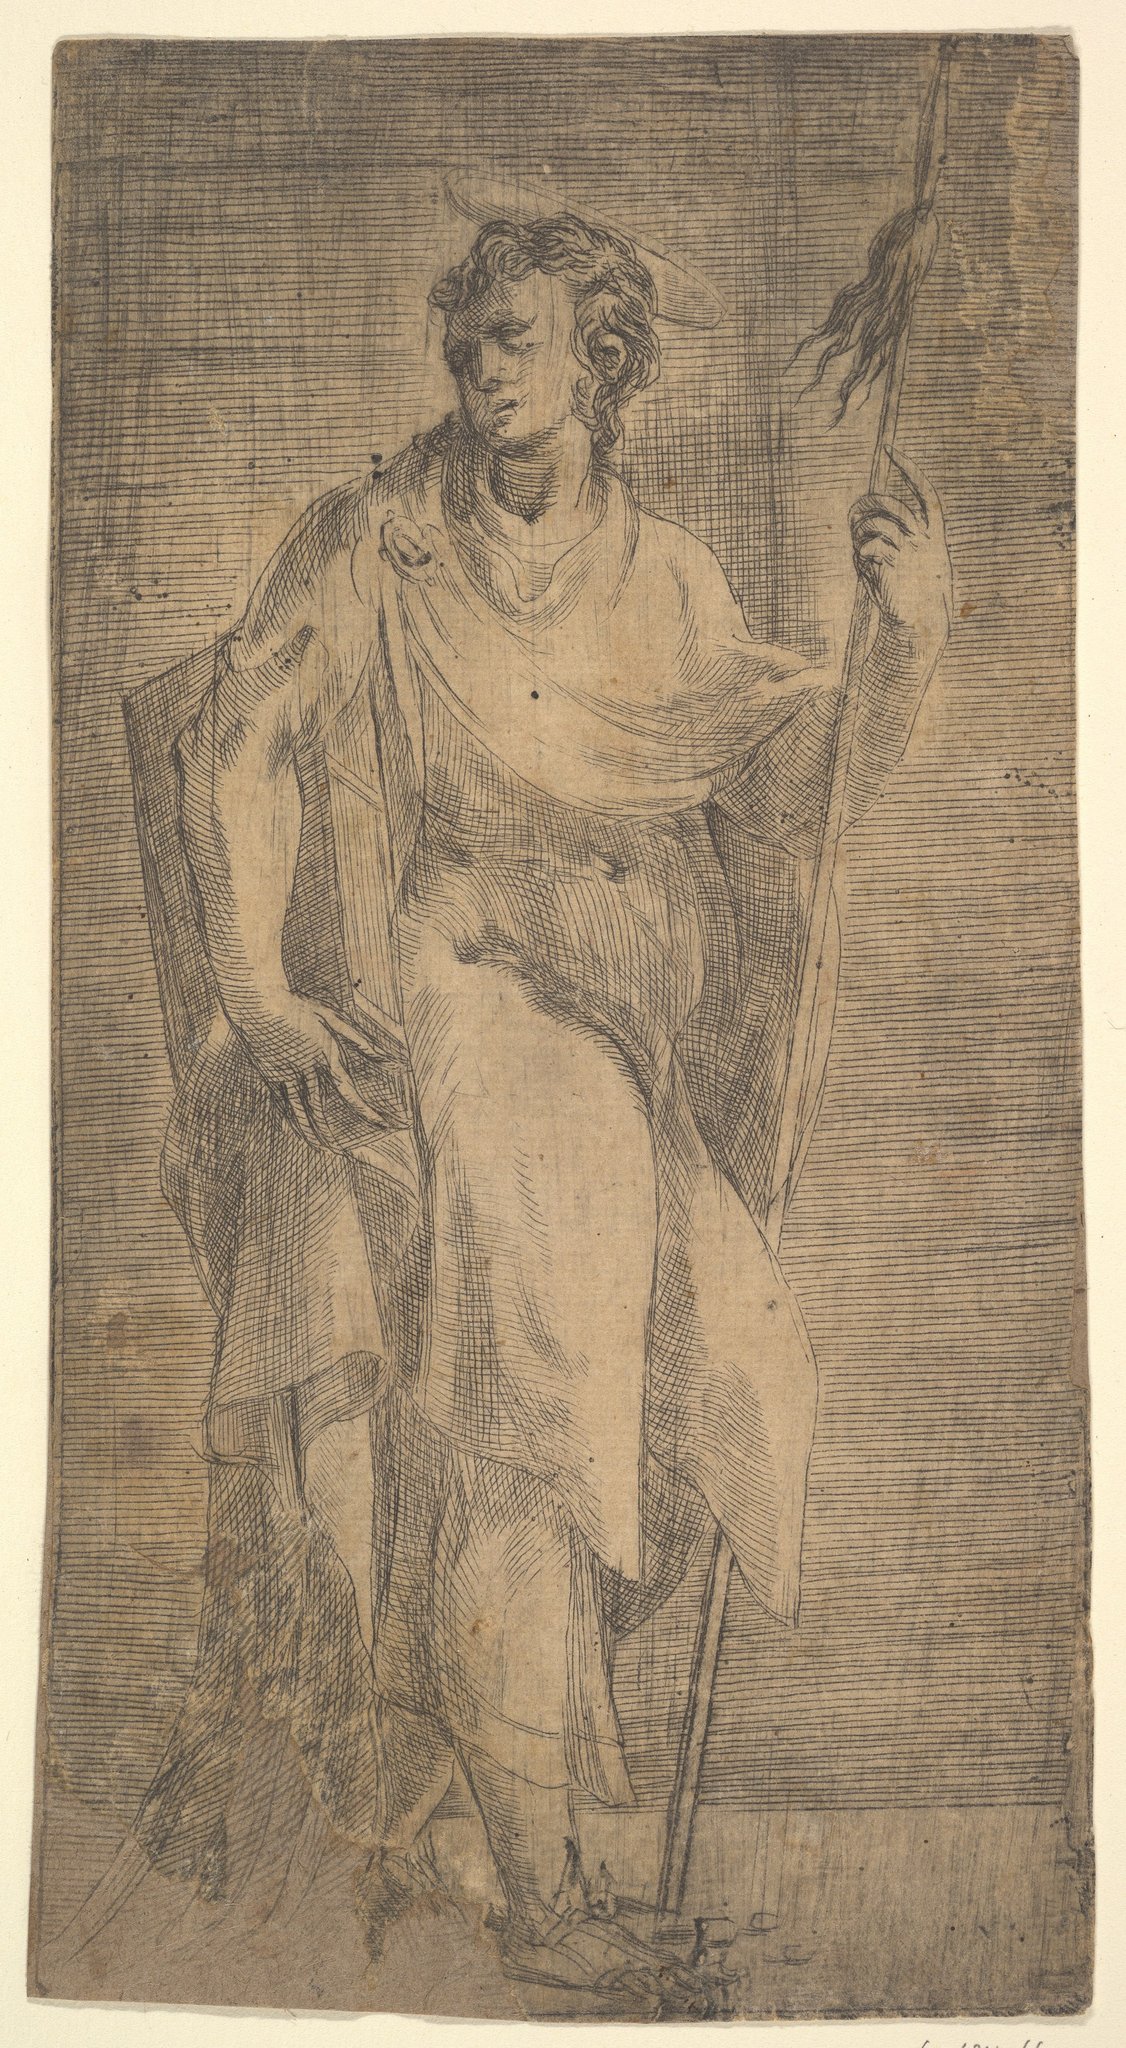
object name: print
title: A saint, possibly Matthew, holding a staff and a book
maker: andrea schiavone (andrea meldola)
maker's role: artist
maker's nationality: italian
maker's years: 1510-1563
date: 1540-1550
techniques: etching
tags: books,saint matthew